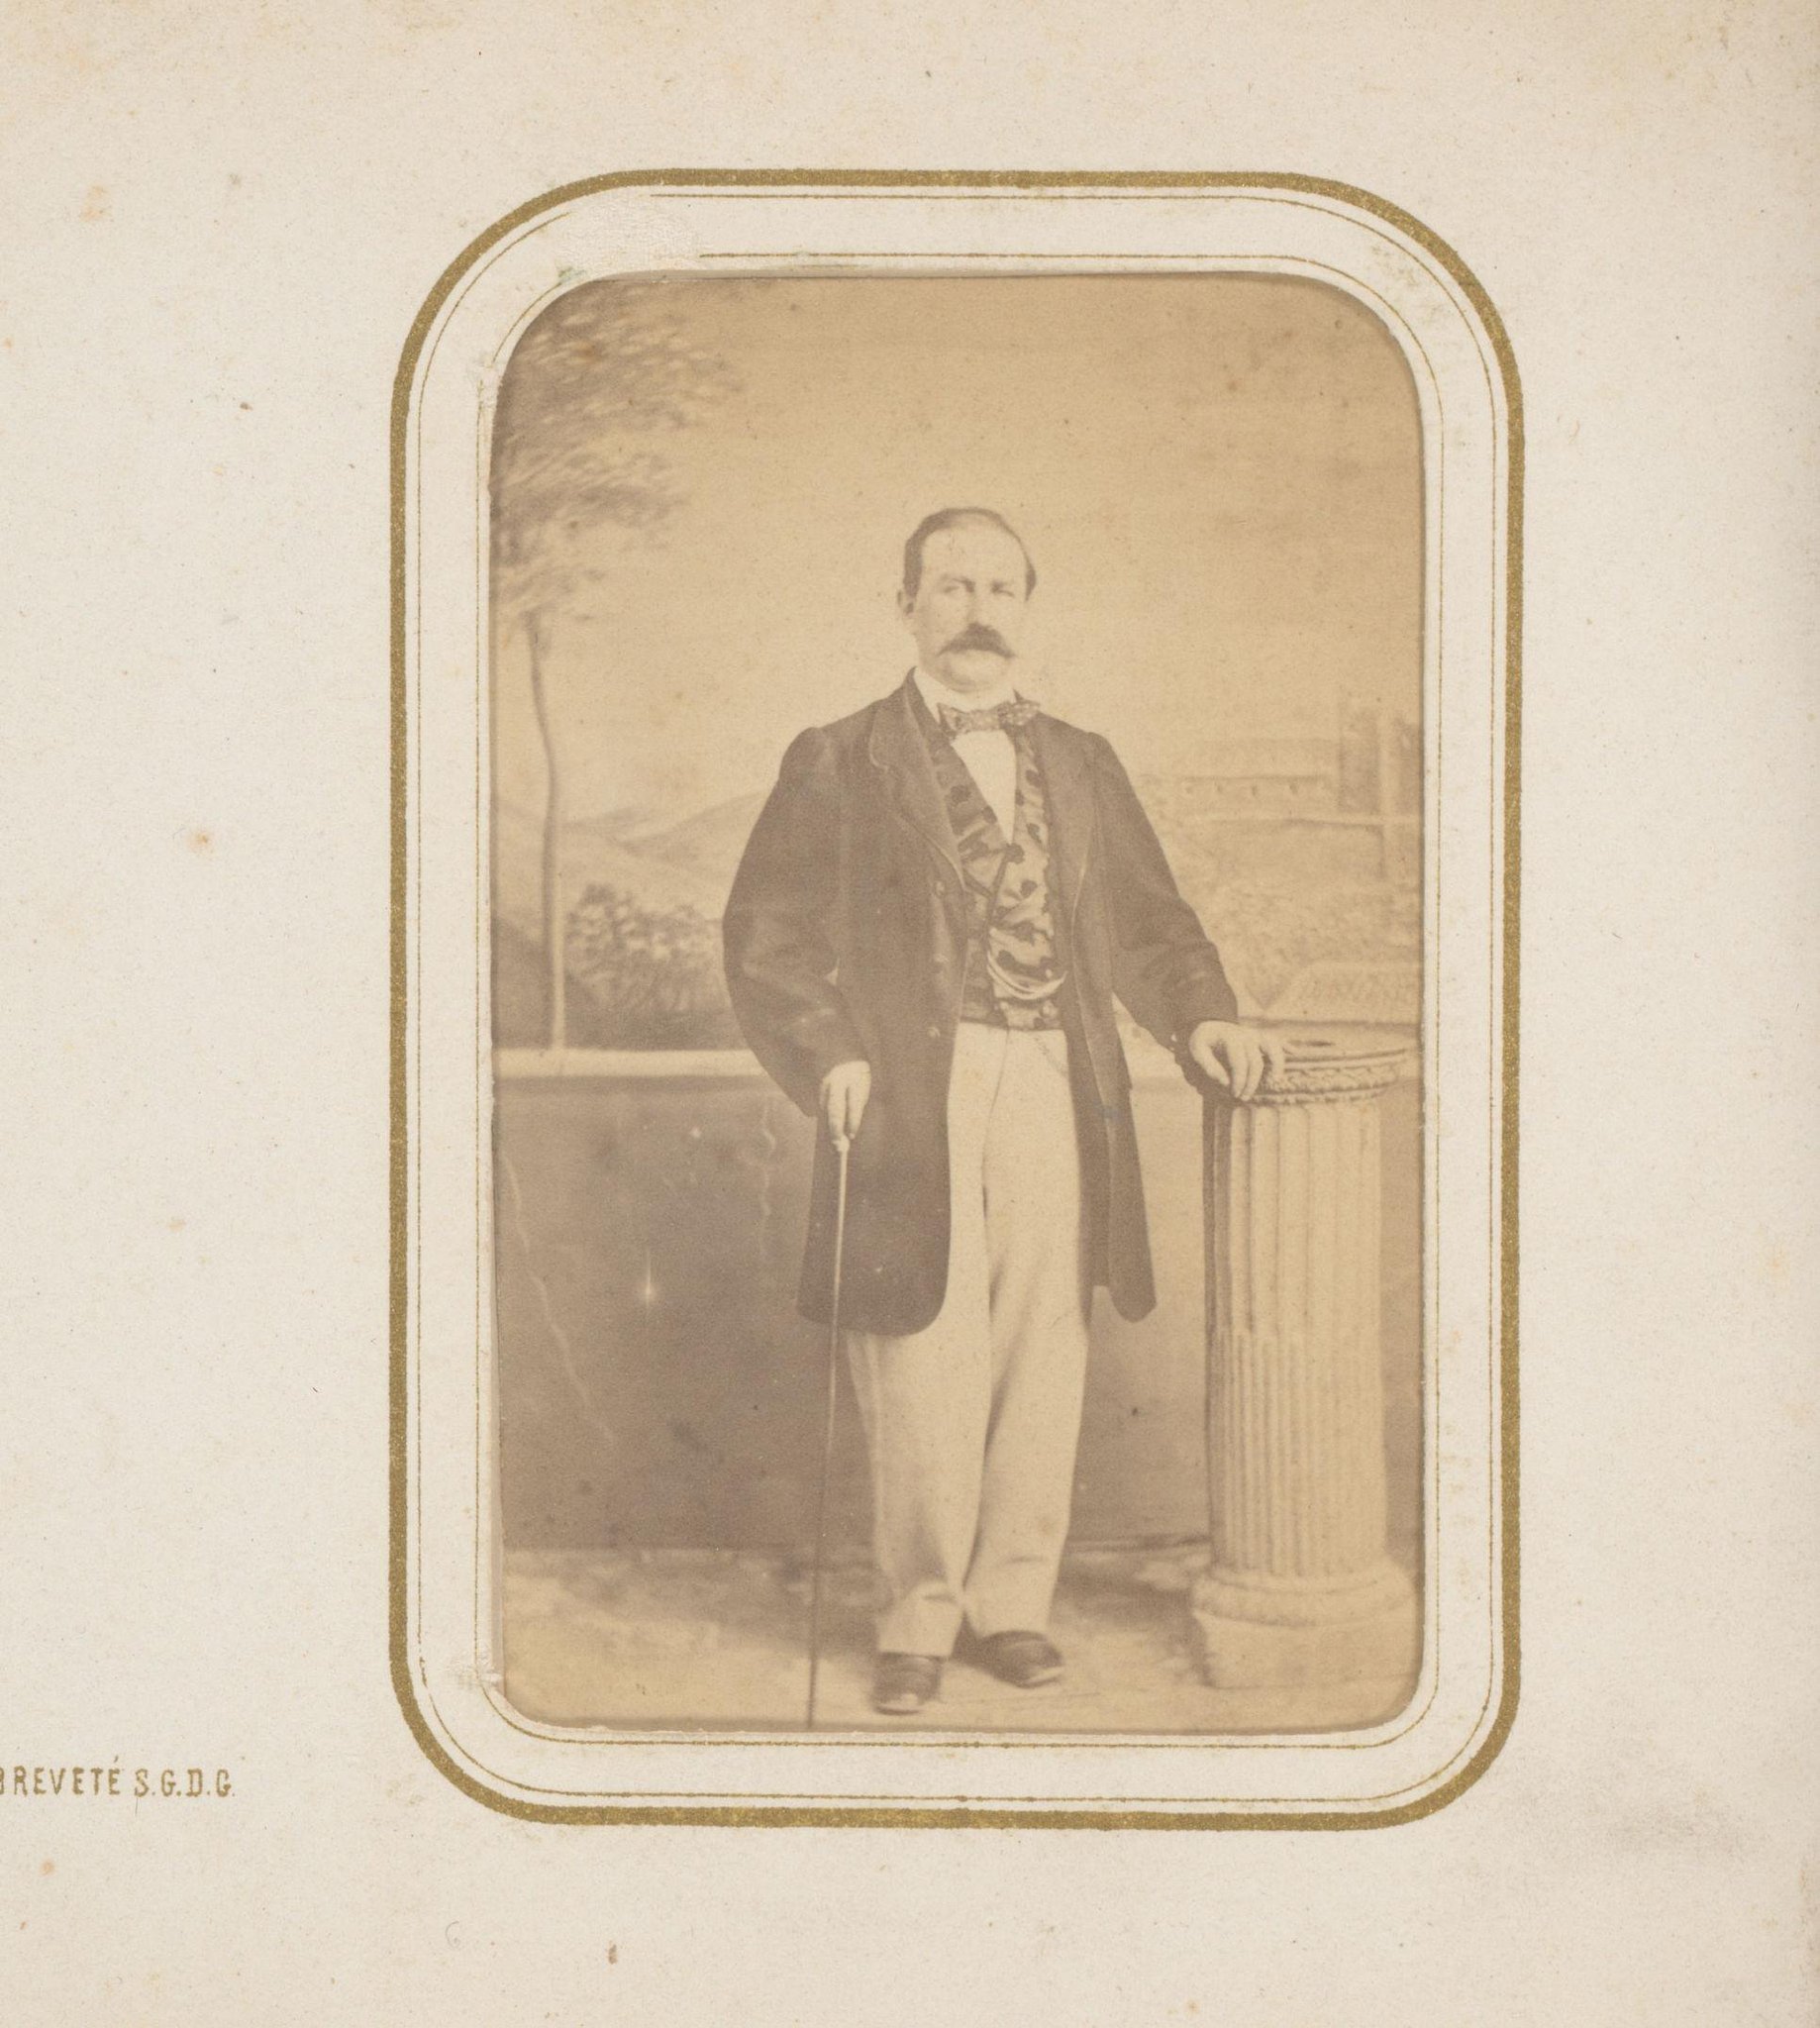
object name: photograph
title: Portret van een man met een snor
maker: Anonymous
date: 1860-1900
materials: cardboard, photographic support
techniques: albumen print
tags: moustache, adult man, historical persons